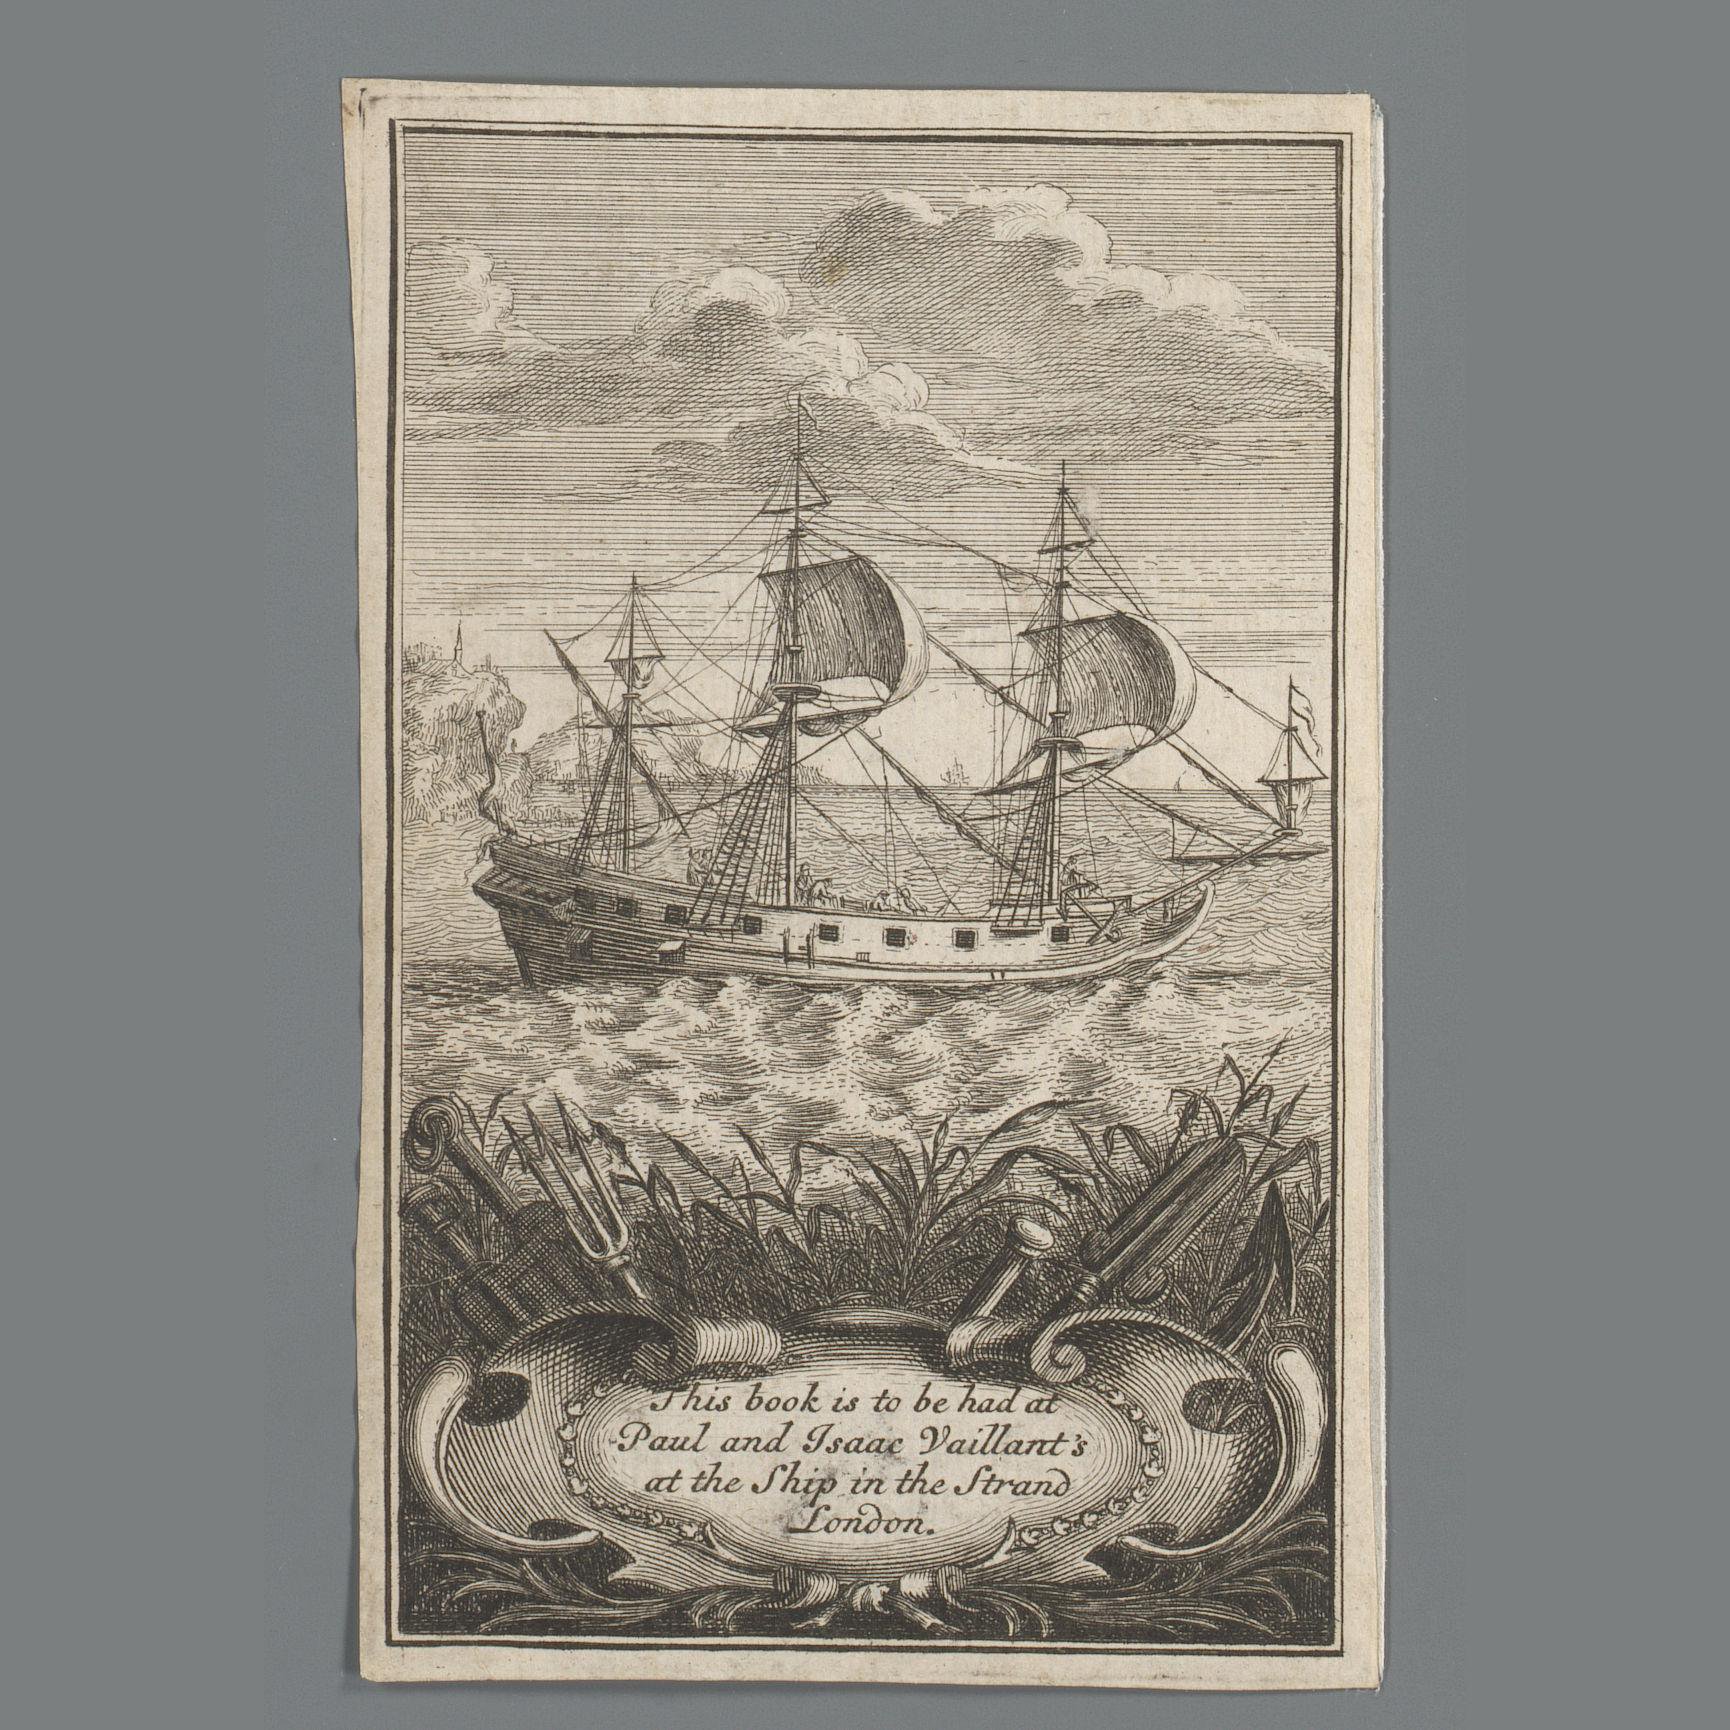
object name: business card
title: Adreskaart van de boekhandel van Paul en Isaac Vaillant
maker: Anonymous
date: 1690-1730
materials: paper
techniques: engraving, etching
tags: sailing-ship, sailing-boat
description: Een zeilschip op zee, met daaronder een rietkraag en een cartouche met daarin de tekst: 'This book is to be had at Paul and Isaac Vaillant's at the Ship in the Strand London'.